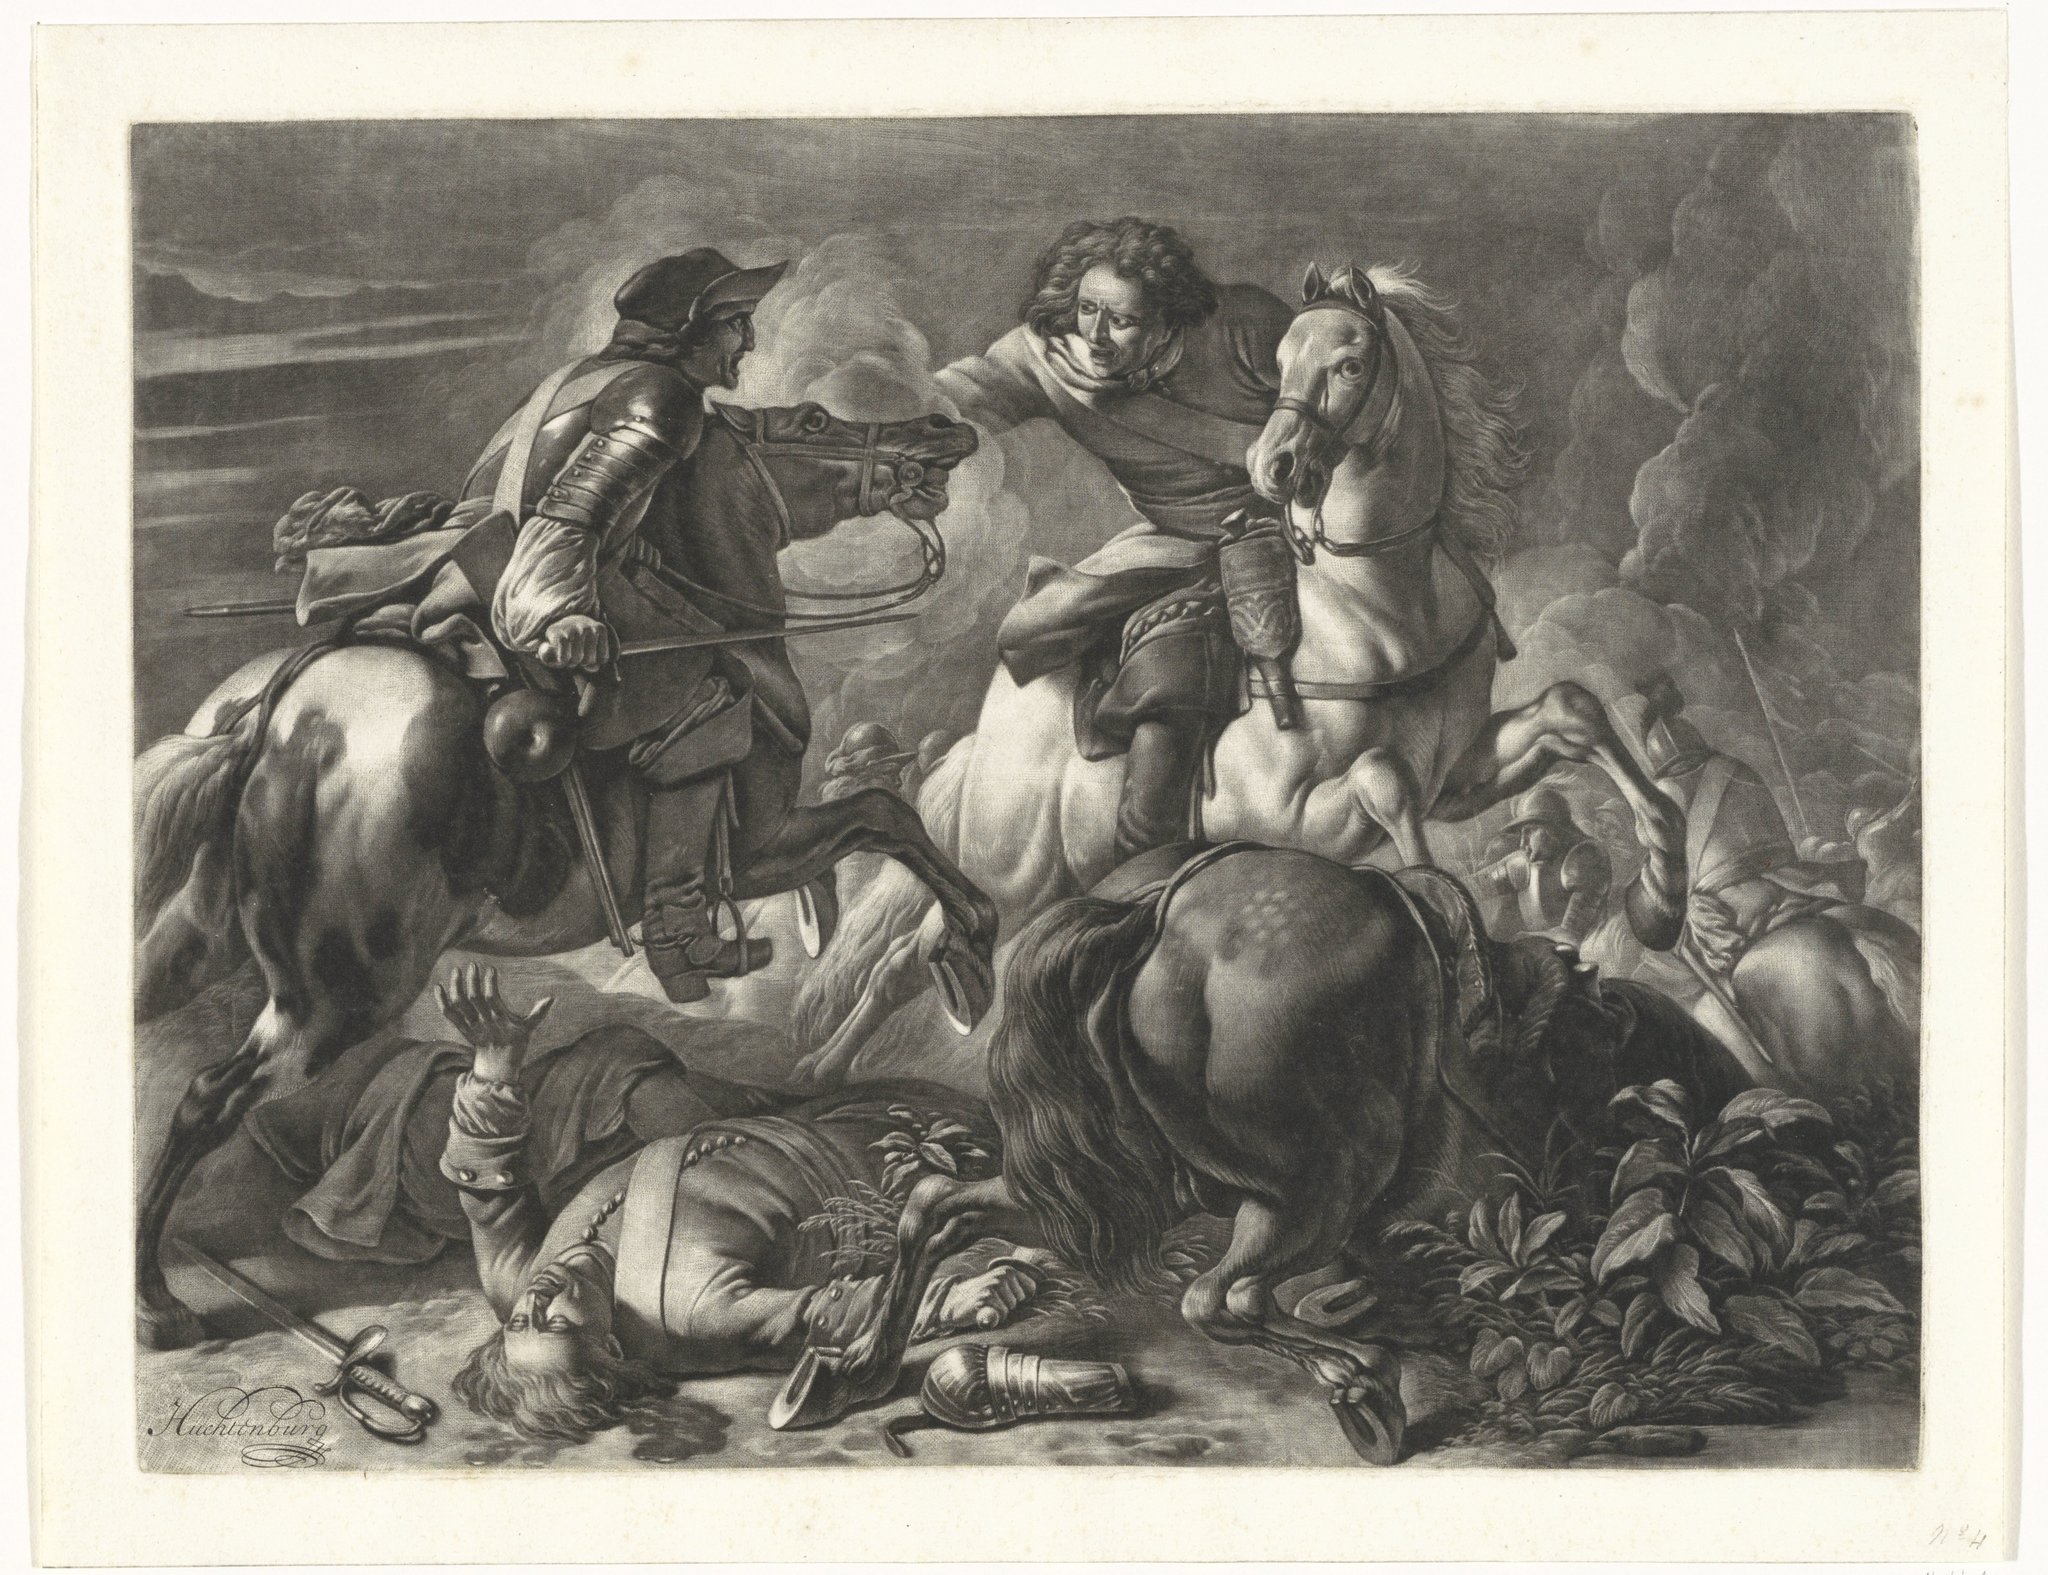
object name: print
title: Ruitergevecht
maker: jan van huchtenburg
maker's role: draughtsman, painter, print maker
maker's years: 1647-1733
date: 1657-1733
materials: paper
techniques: engraving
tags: battle (+ cavalry, horsemen)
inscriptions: collector's mark: Lugt 2228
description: Twee ruiters zijn met elkaar in gevecht. De ene heeft zijn wapen afgevuurd en de ander houdt zijn ontblote zwaard paraat. Op de grond gewonde en stervende soldaten en paarden. Op de achtergrond een woelig strijdtoneel. De prent maakt deel uit van een serie van vier met ruiters.